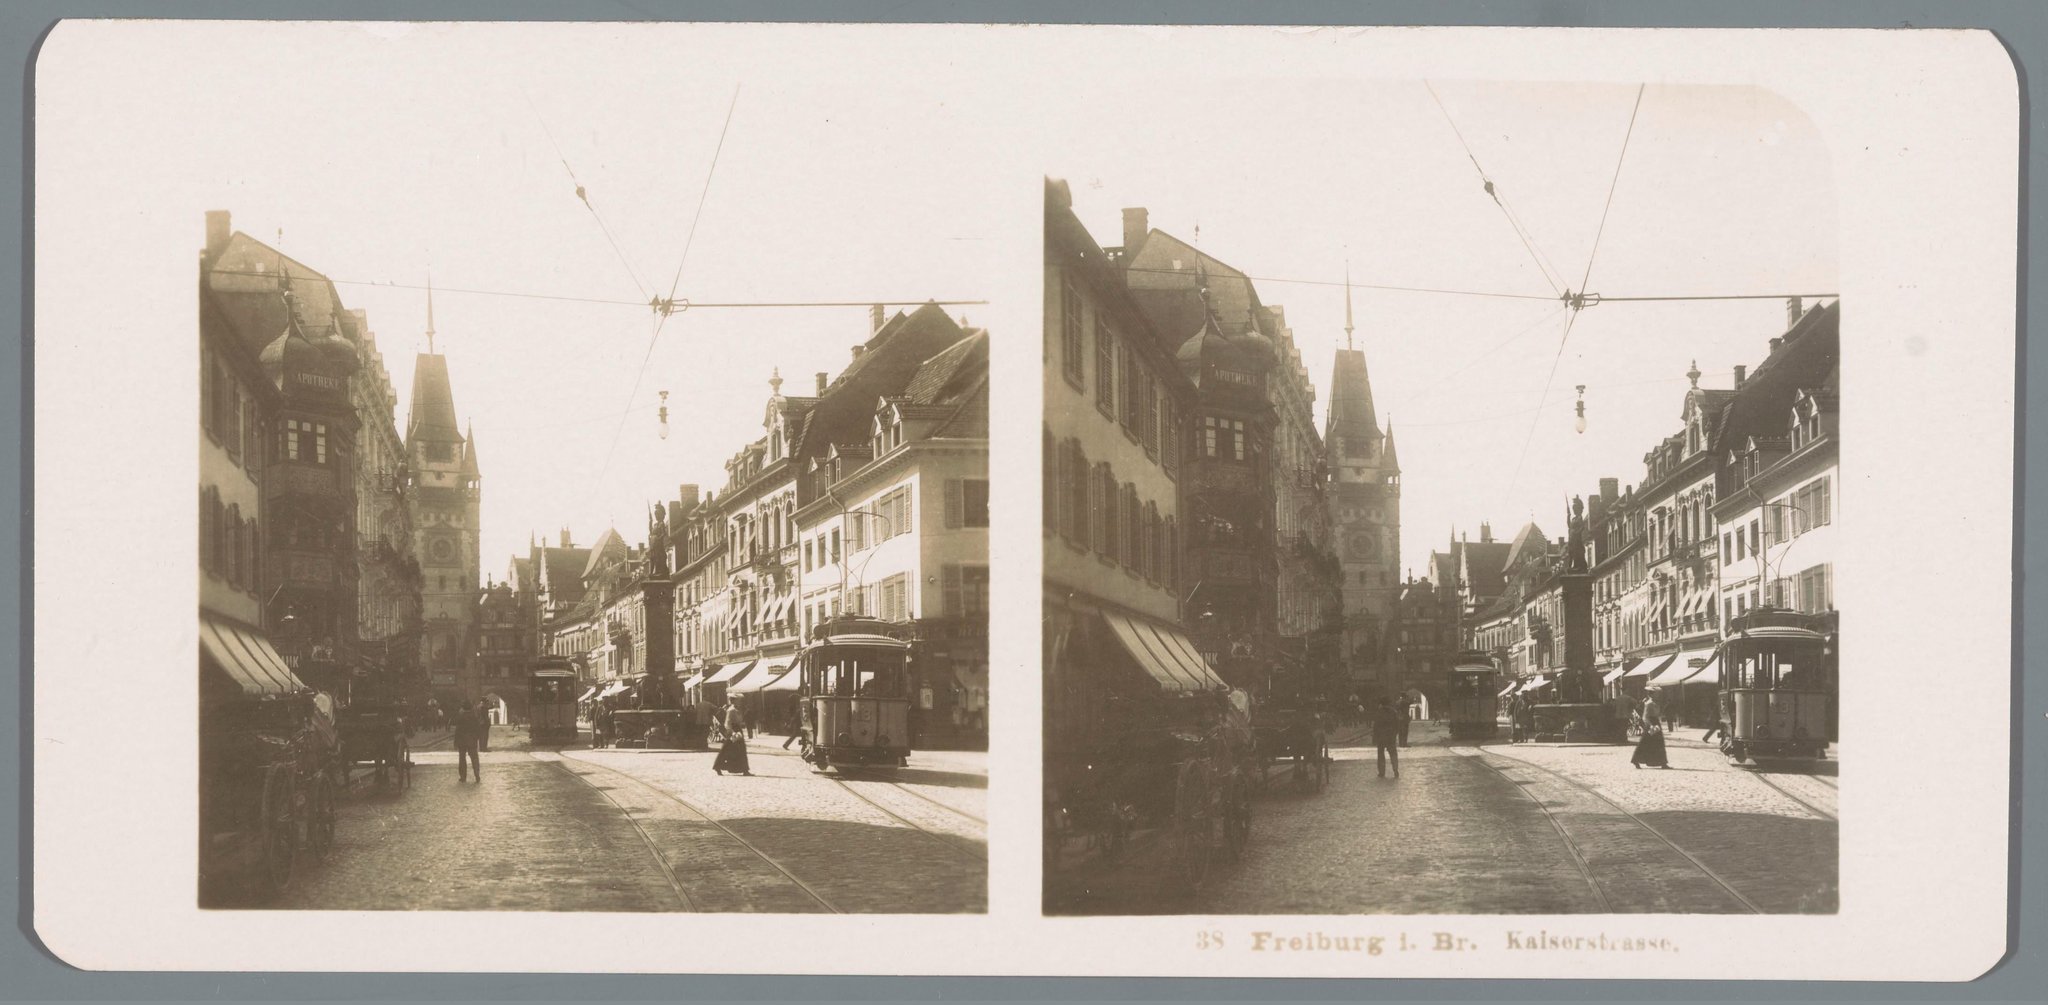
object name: stereograph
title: Freiburg I. Br. Kaiserstrasse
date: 1906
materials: cardboard, photographic support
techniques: gelatin silver print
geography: freiburg im breisgau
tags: façade (of house or building), street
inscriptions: inscription: ‘Neue Photographische Gesellschaft A. G., Steglitz-Berlin 1906.’, number: ‘38’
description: RP-F-00-9049 is een ander exemplaar van dezelfde foto.